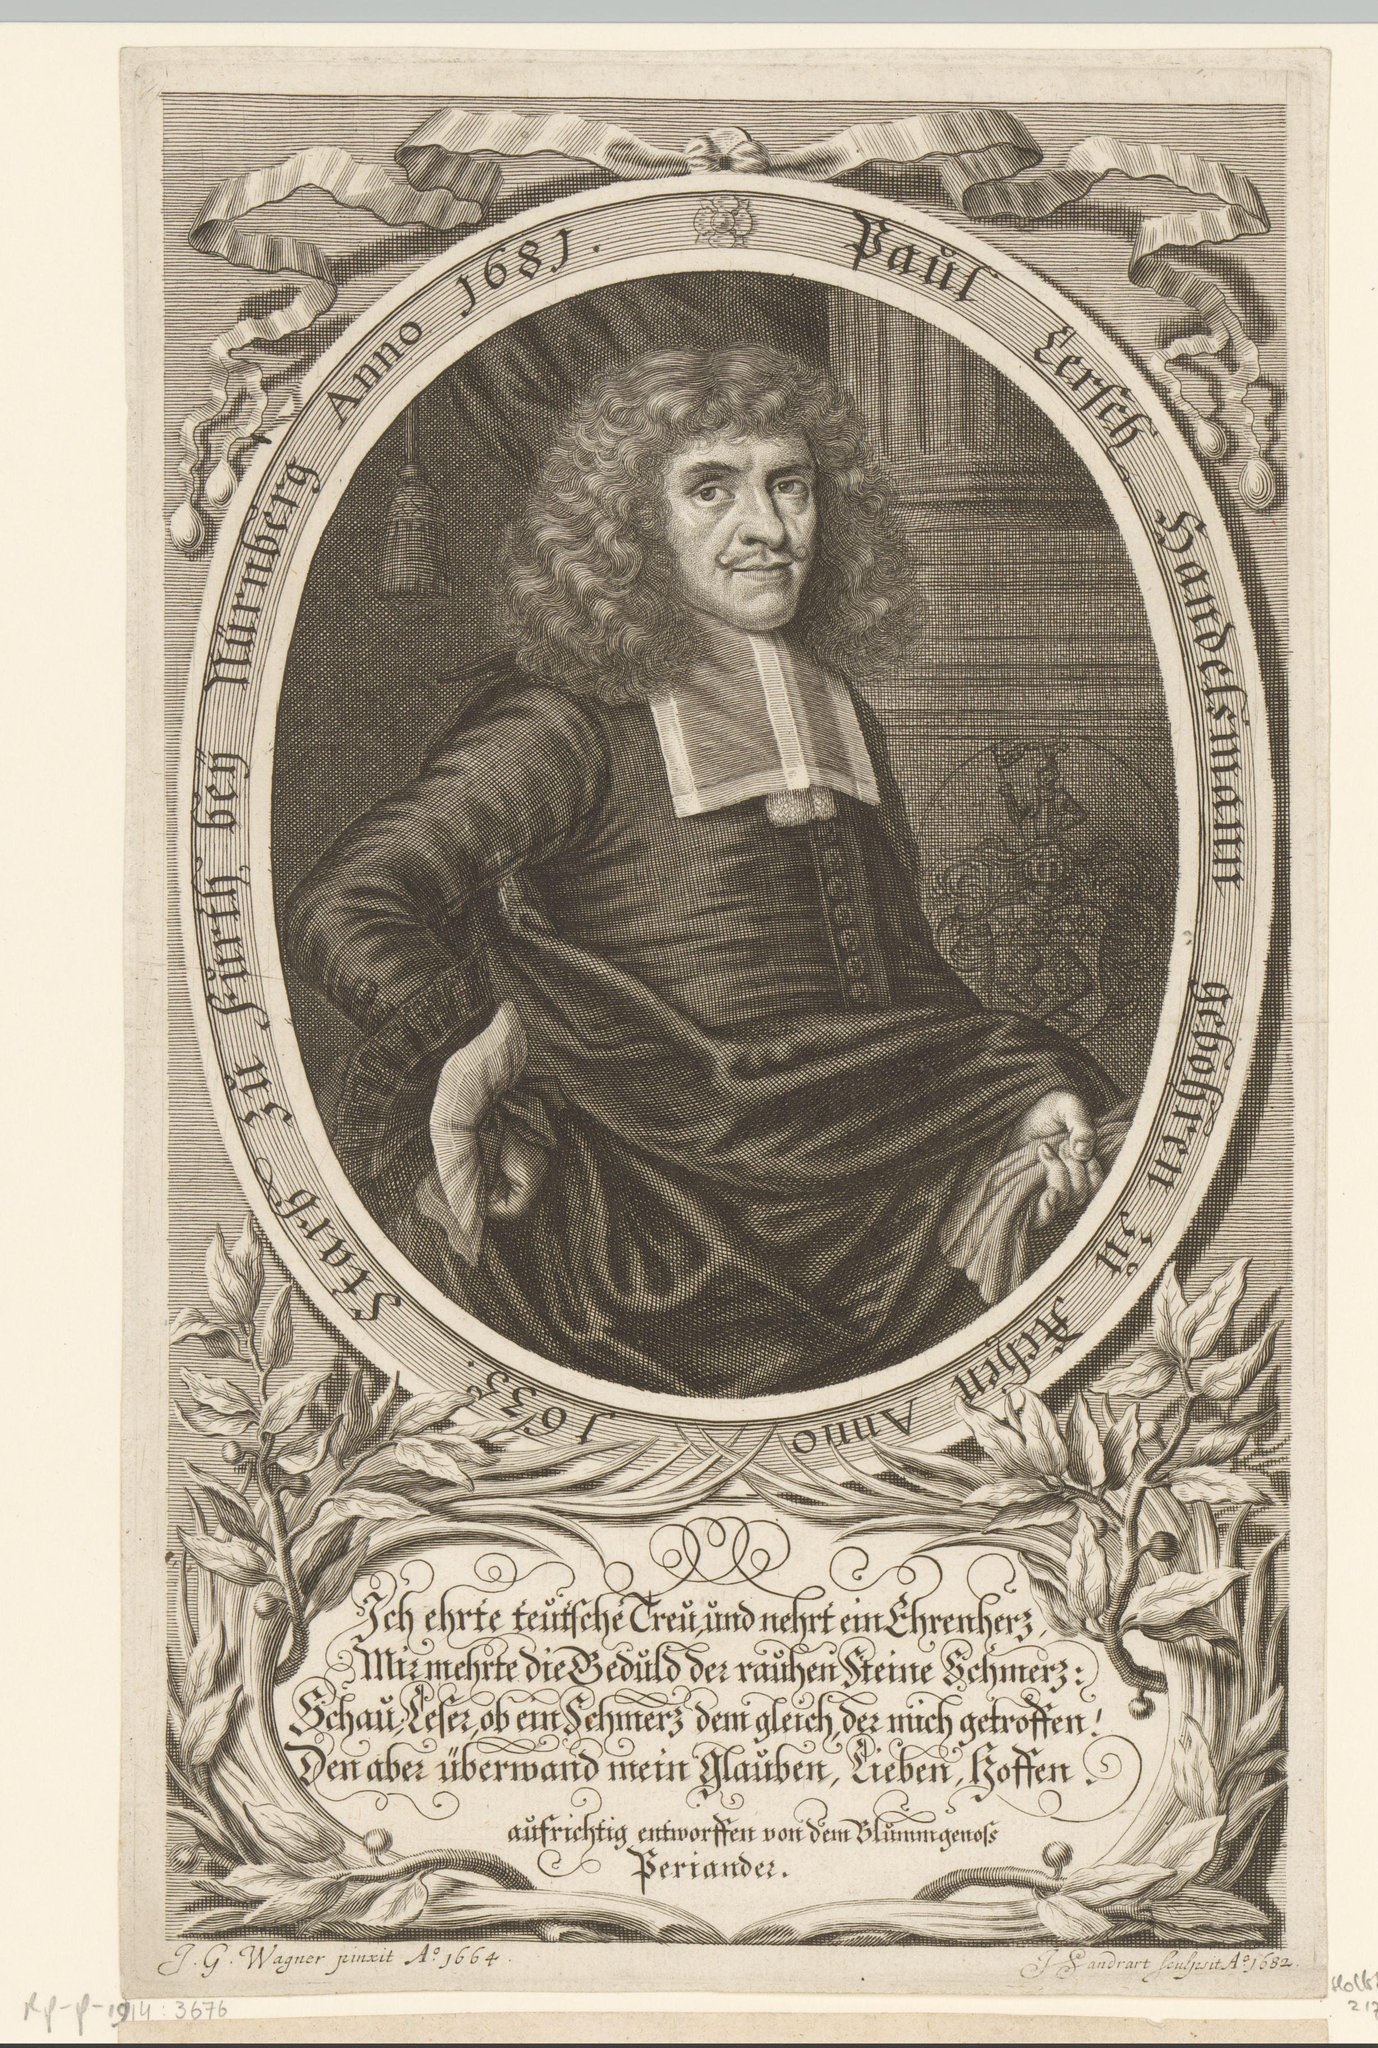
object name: print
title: Portret van Paul Lersch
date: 1682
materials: paper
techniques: engraving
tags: historical persons, armorial bearing, heraldry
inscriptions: collector's mark: Lugt 2228